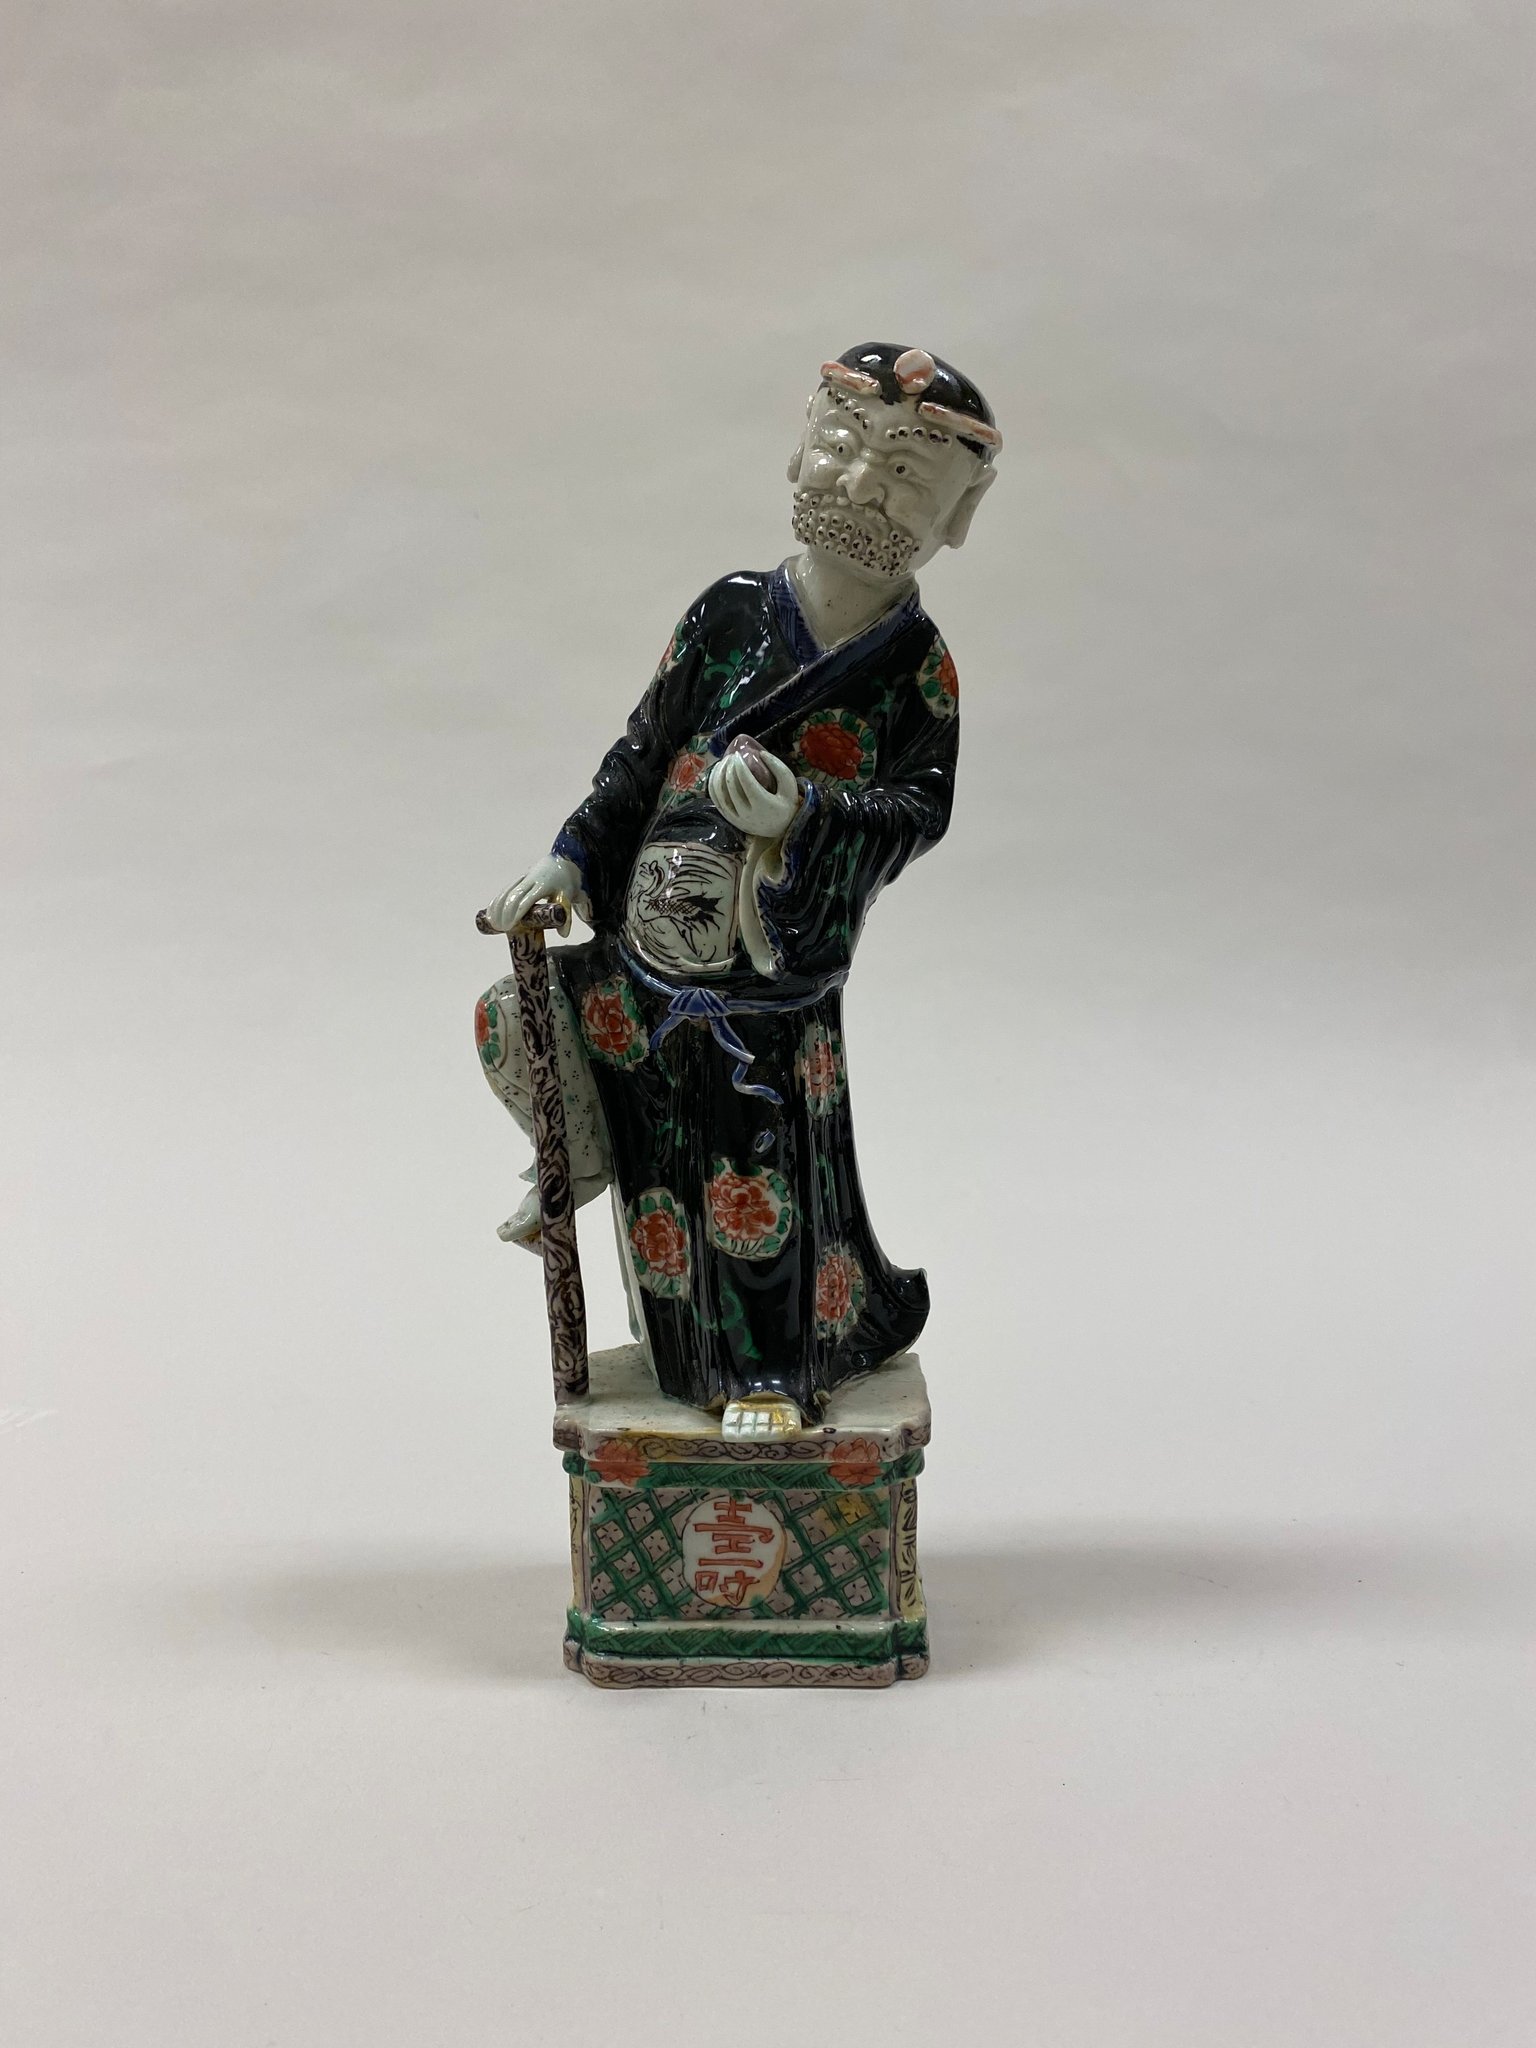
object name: figure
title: Figure of Li Tieguai, one of the Eight Immortals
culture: chinese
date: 1801-1900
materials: biscuit, enamel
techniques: polychrome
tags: peaches,men